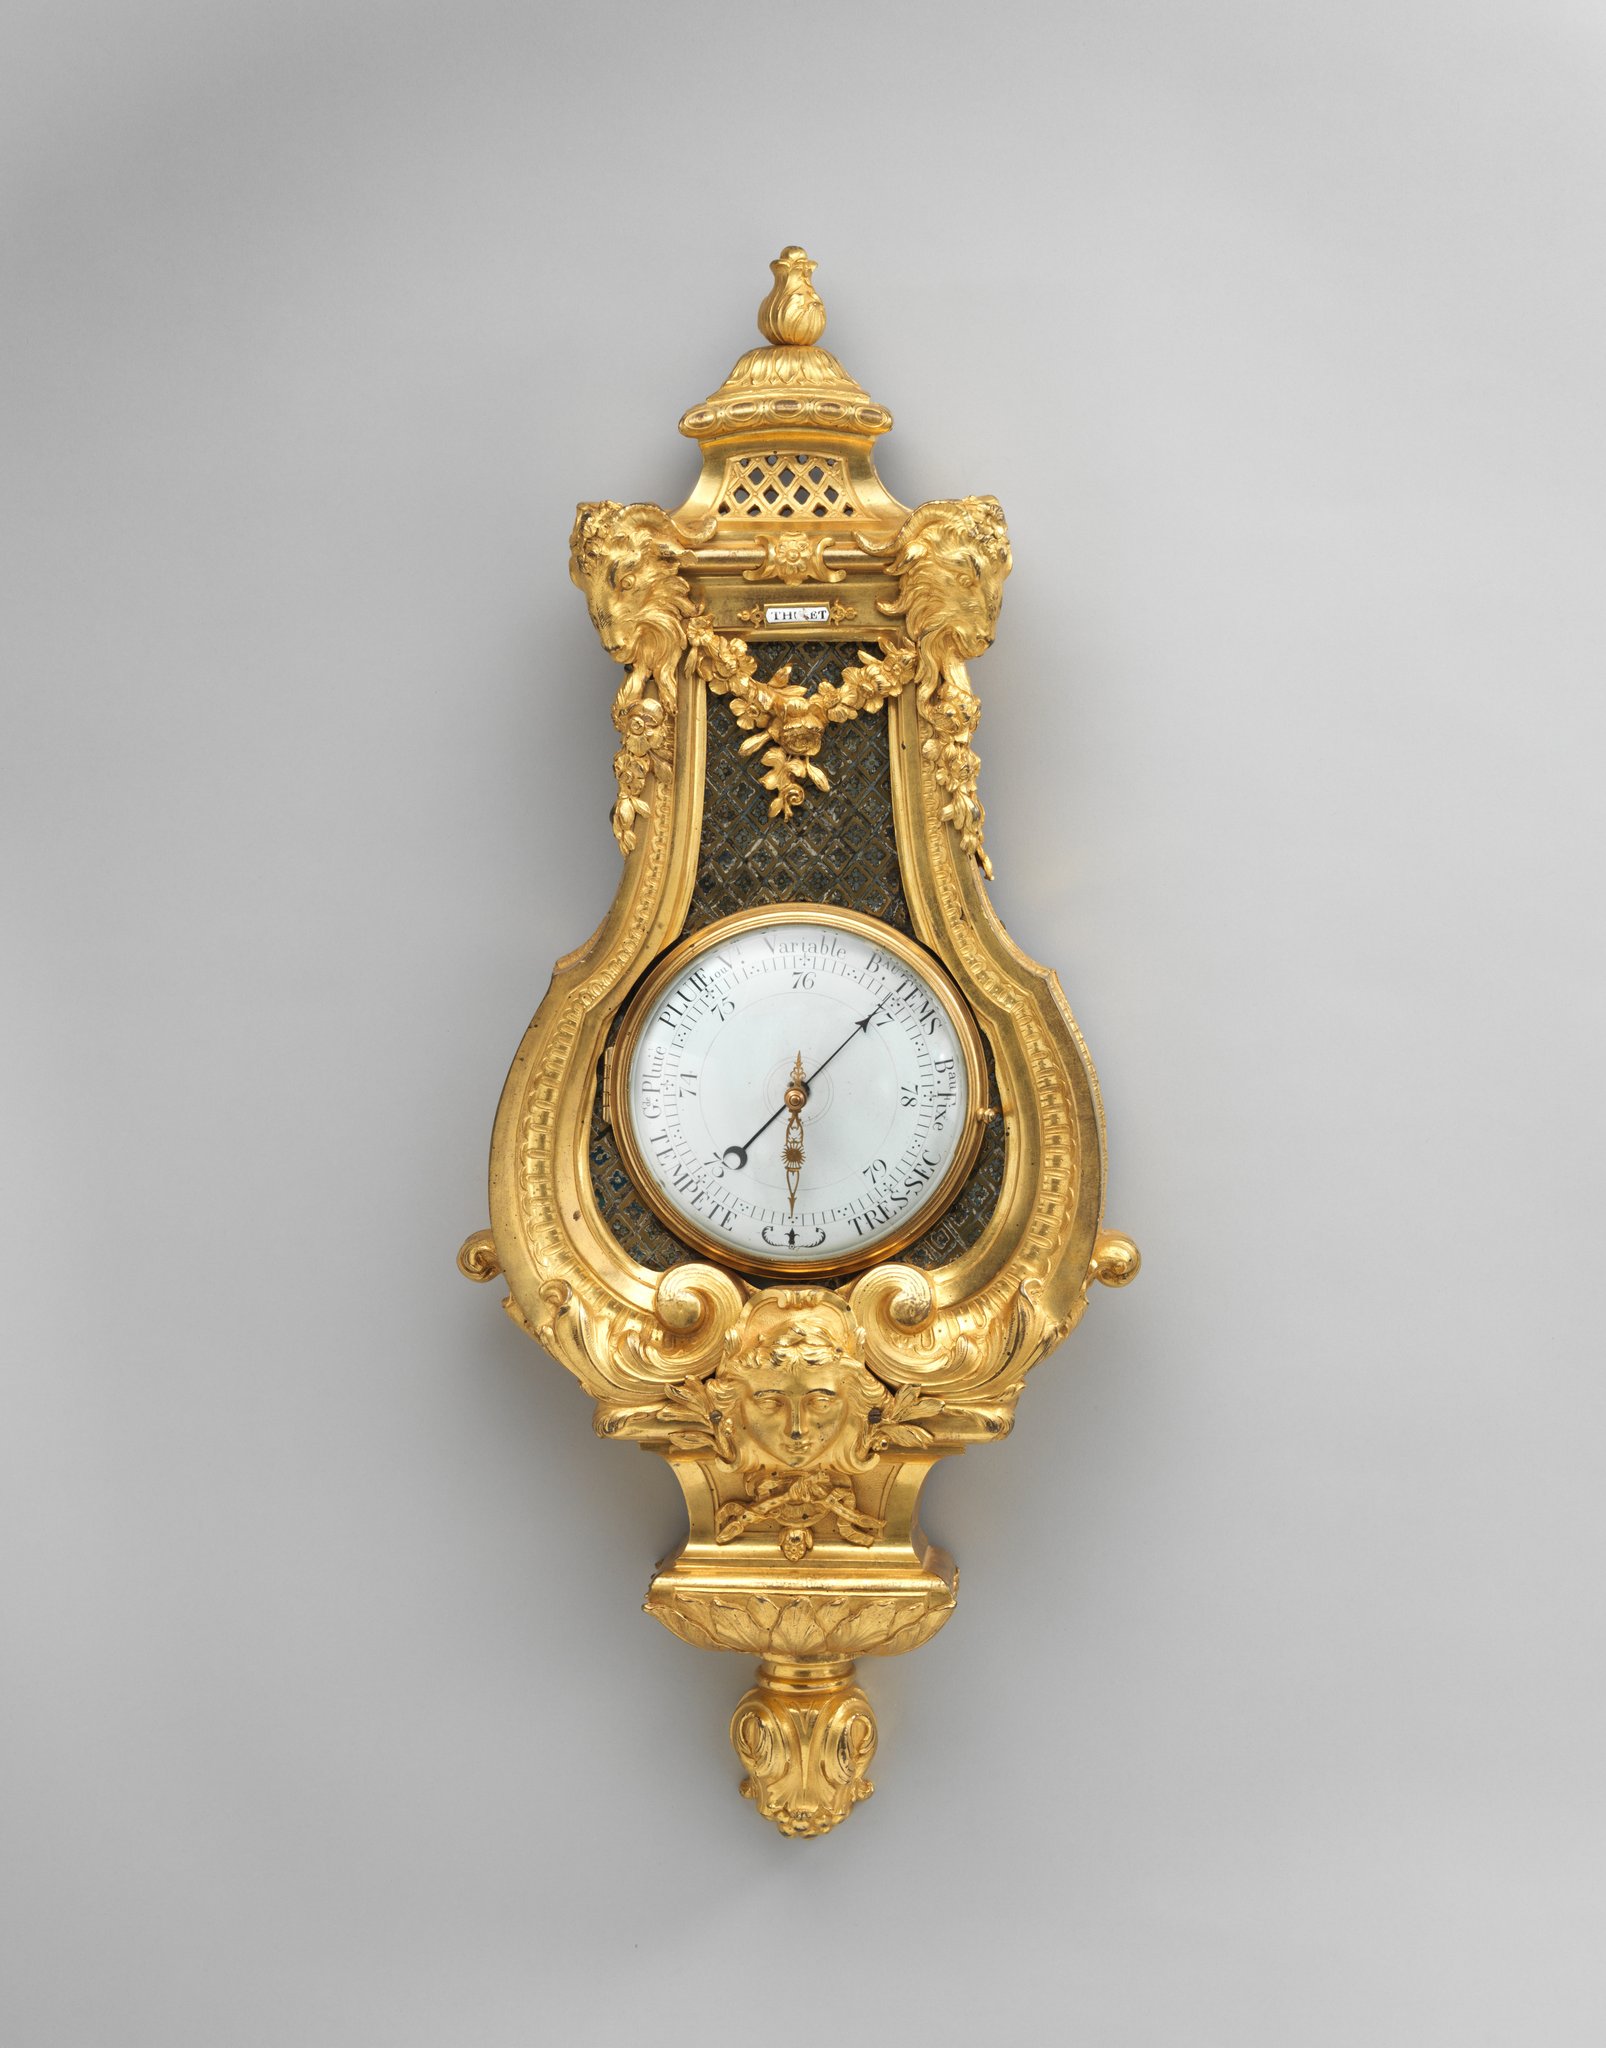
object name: cartel barometer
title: Cartel barometer (one of a pair)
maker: andré charles boulle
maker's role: maker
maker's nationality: french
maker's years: 1642-1732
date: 1710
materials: bronze, horn, steel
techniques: gilding, inlay